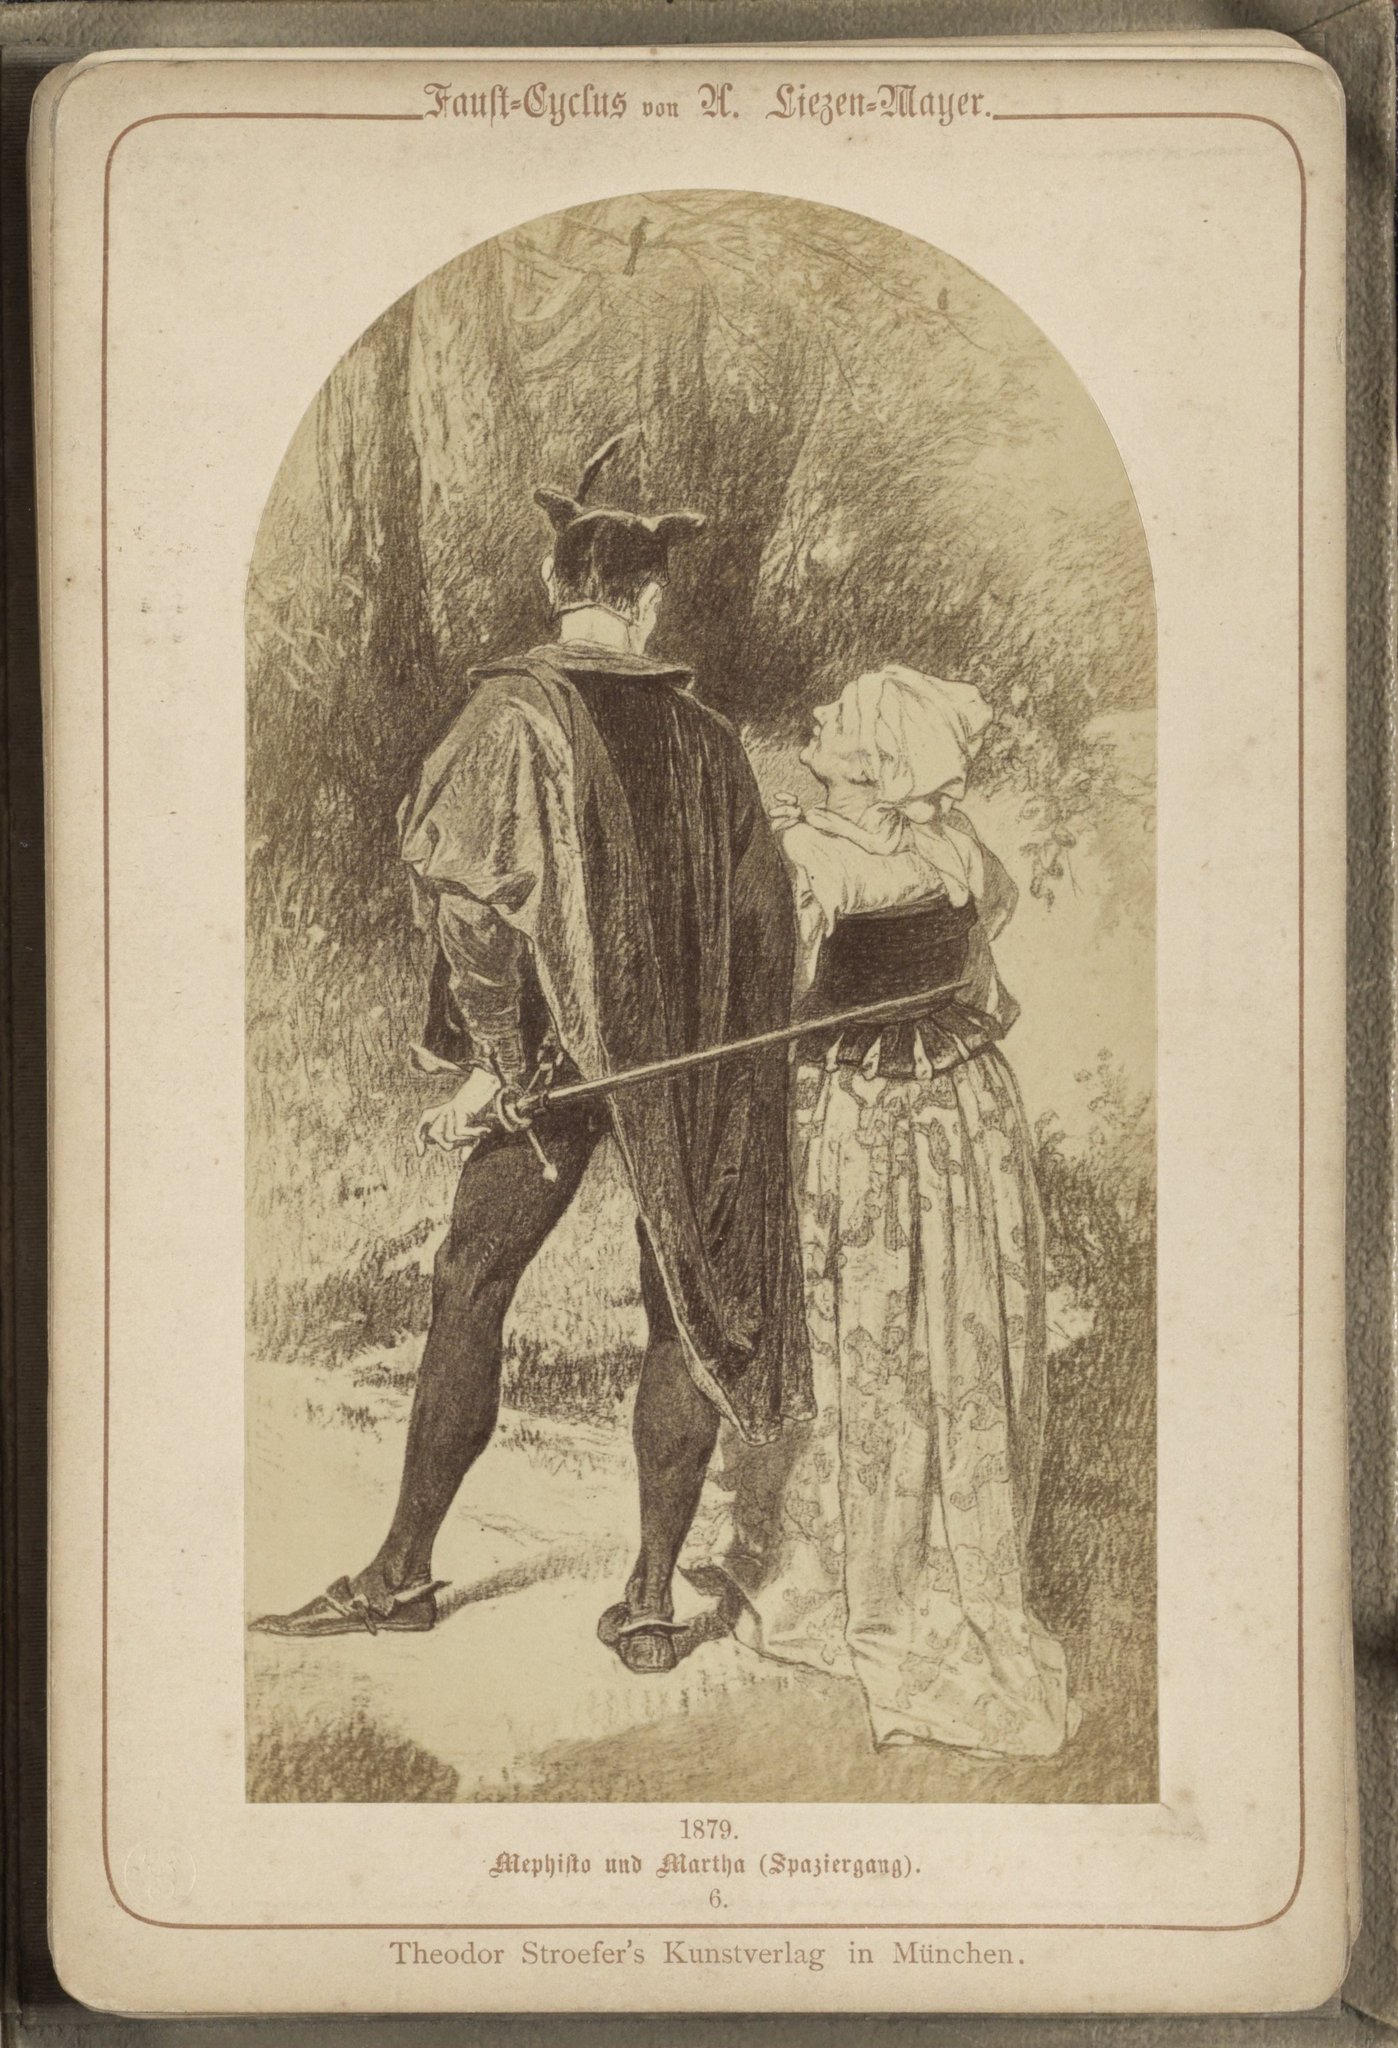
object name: photograph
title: Fotoreproductie van (vermoedelijk) een tekening getiteld 'Wandeling van Mephisto en Martha'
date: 1879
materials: cardboard, paper, photographic support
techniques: albumen print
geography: munich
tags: faust, walking, widow, mephistopheles, name of the demonic tempter in the literary versions of the faust legends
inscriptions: check stamp: ‘TS’, number: ‘6’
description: Onderdeel van Album met 30 fotoreproducties van tekeningen van het Faust-verhaal van J.W. von Goethe.